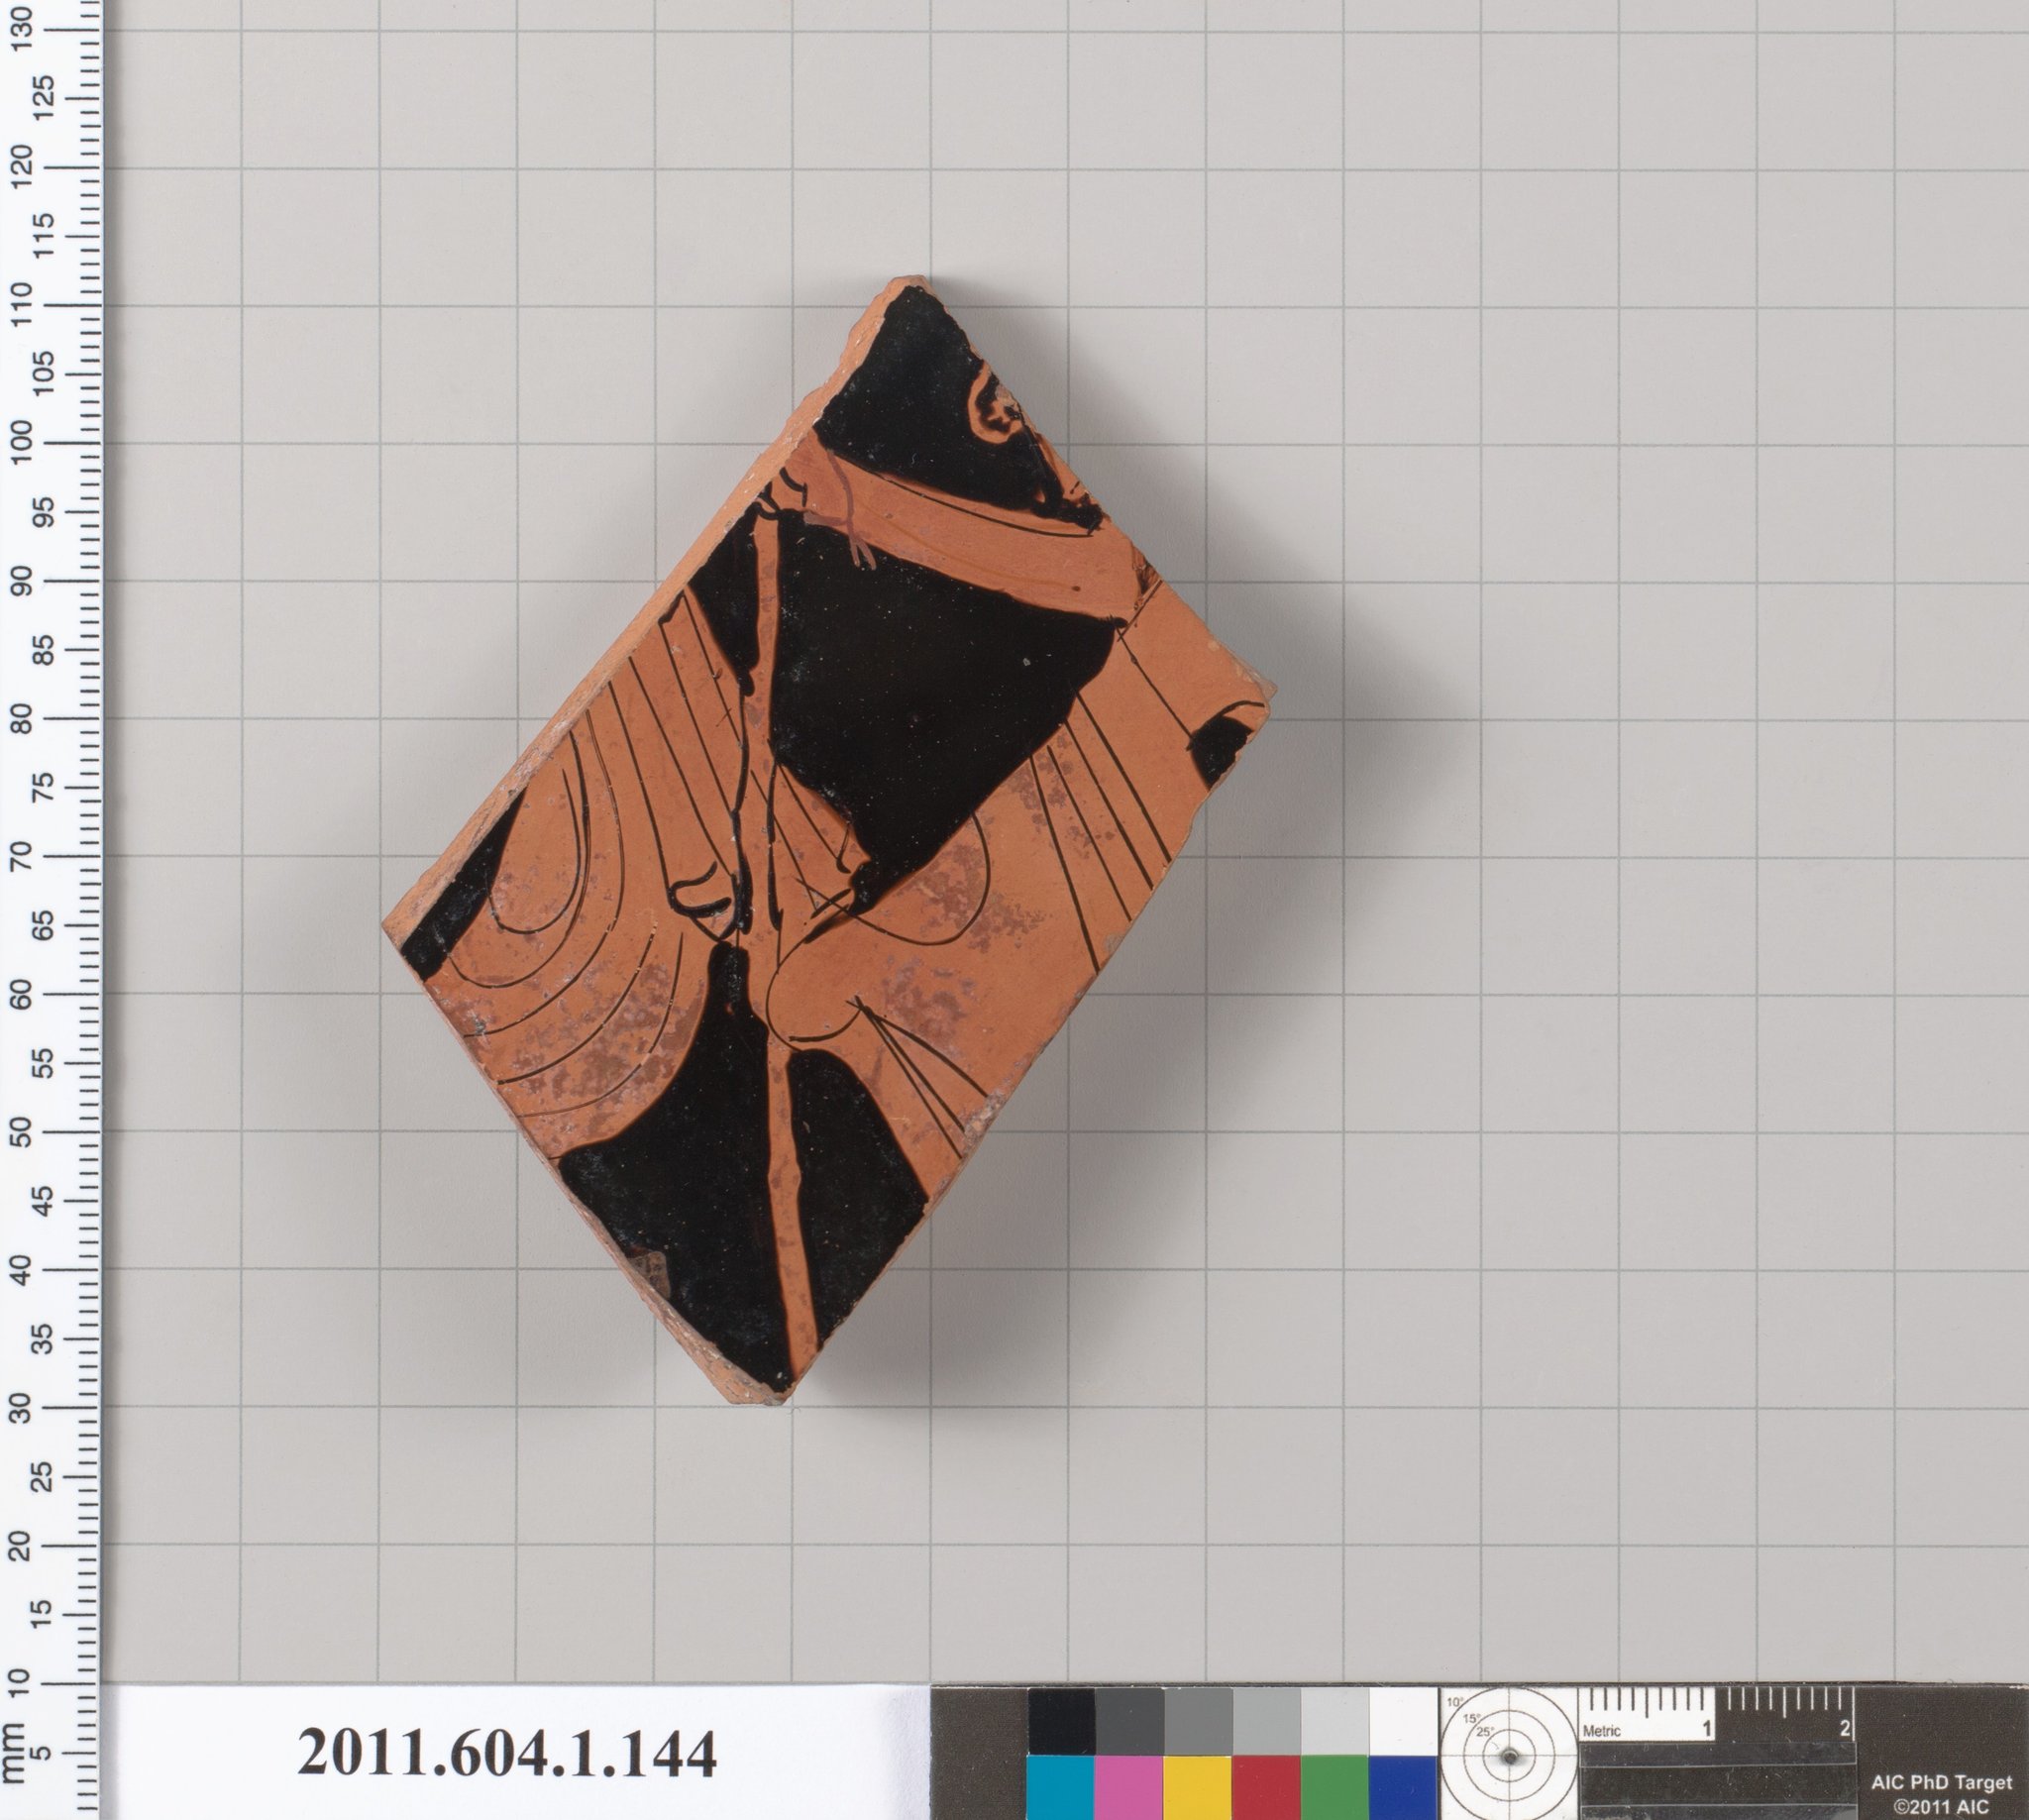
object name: kylix fragment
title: Terracotta fragment of a kylix (drinking cup)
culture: greek, attic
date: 475-451 BCE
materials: terracotta